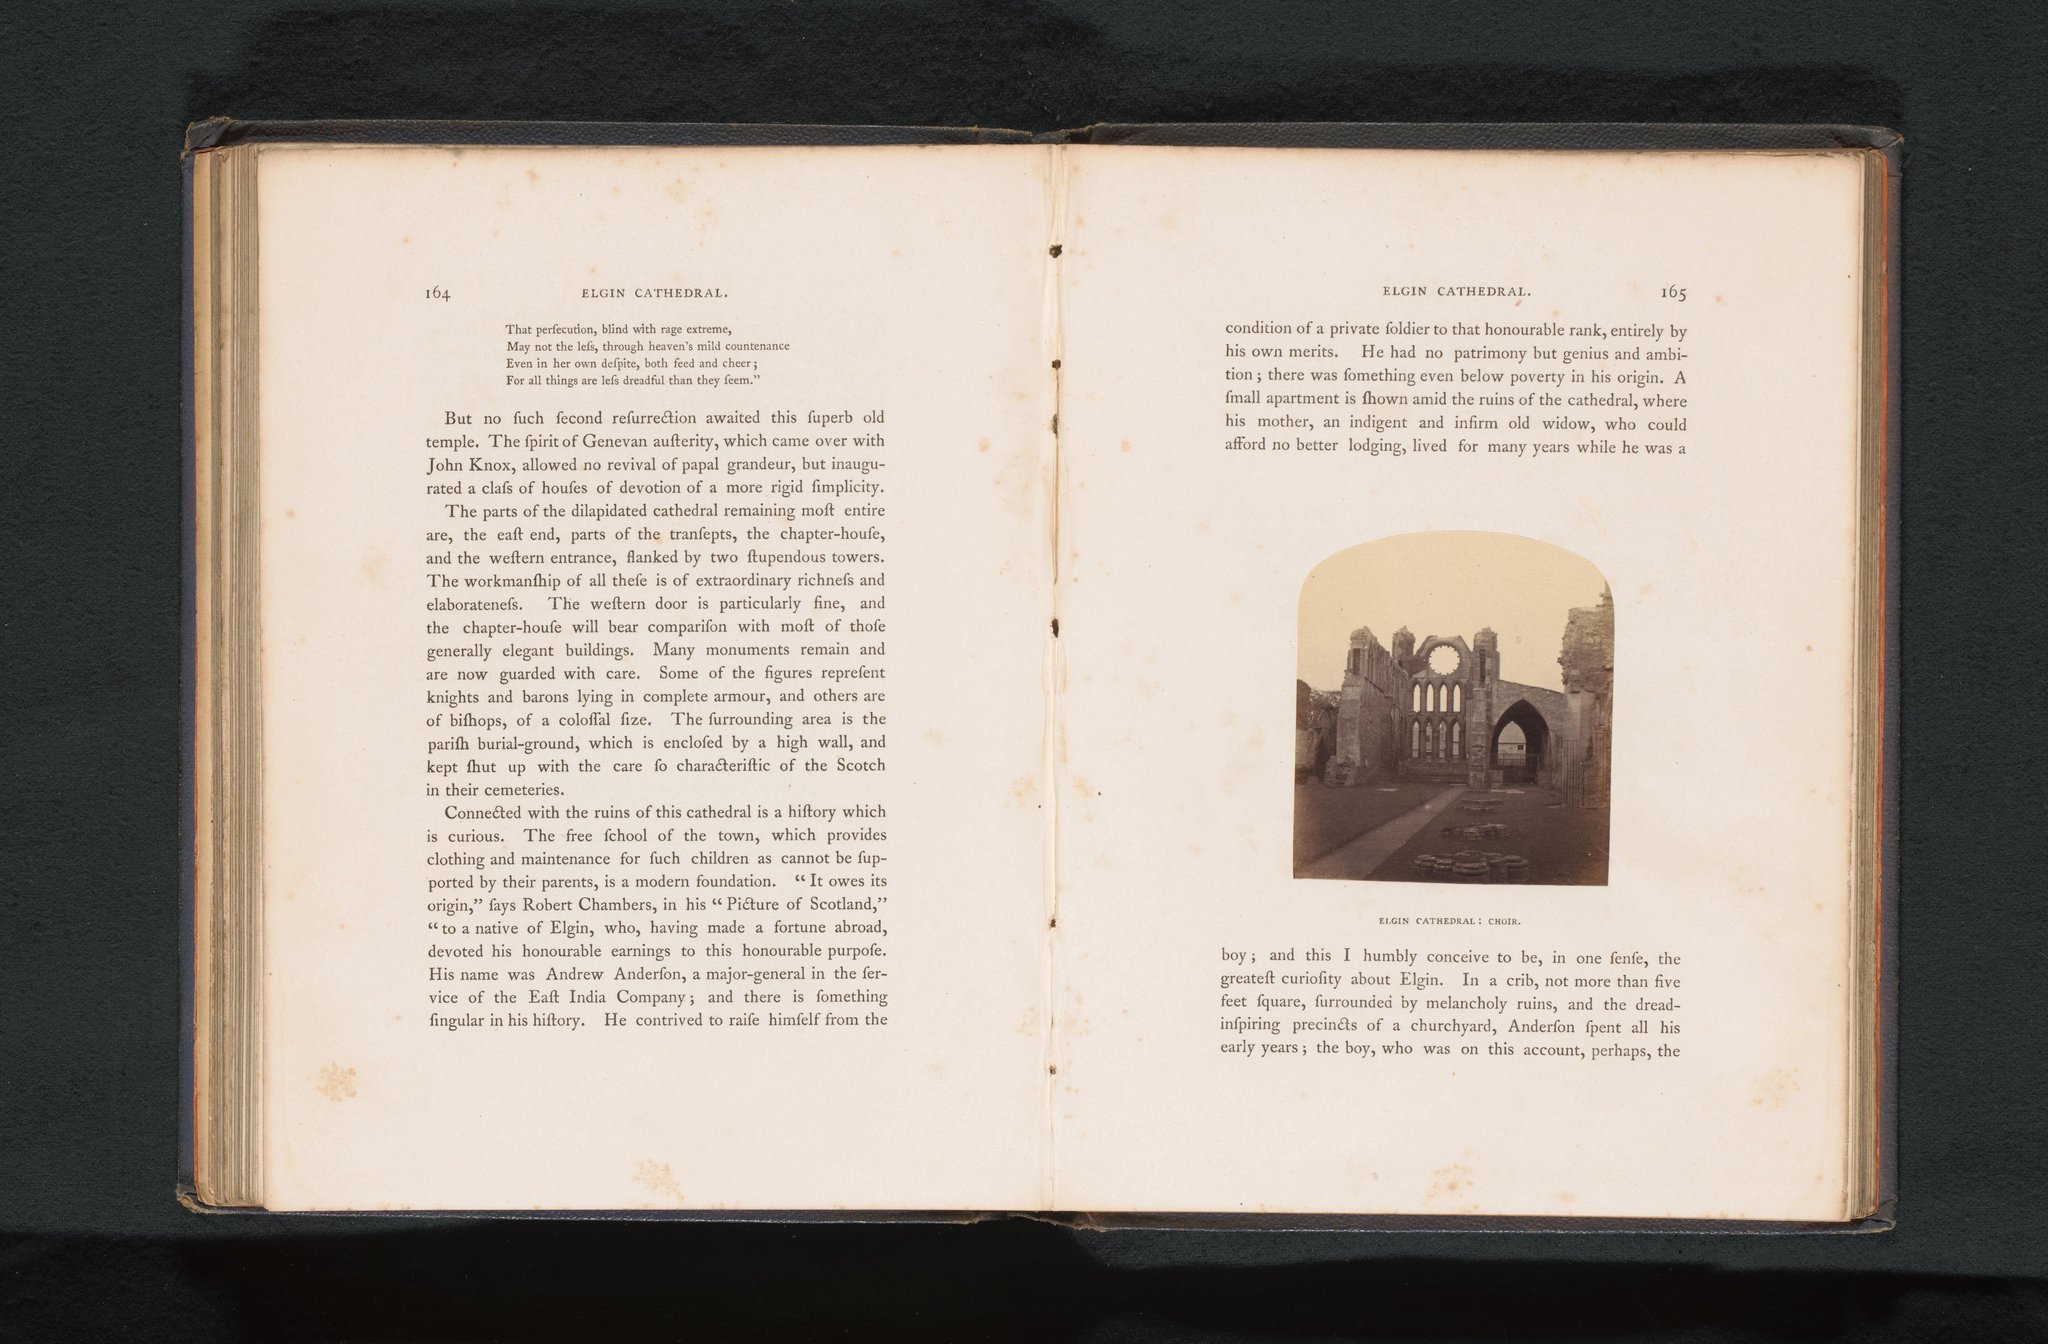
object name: photograph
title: Koor van de Elgin Cathedral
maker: george washington wilson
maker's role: publisher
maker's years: 1823-1893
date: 1857-1862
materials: photographic support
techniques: albumen print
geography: elgin cathedral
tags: ruin of church, monastery, etc., parts of church interior: choir